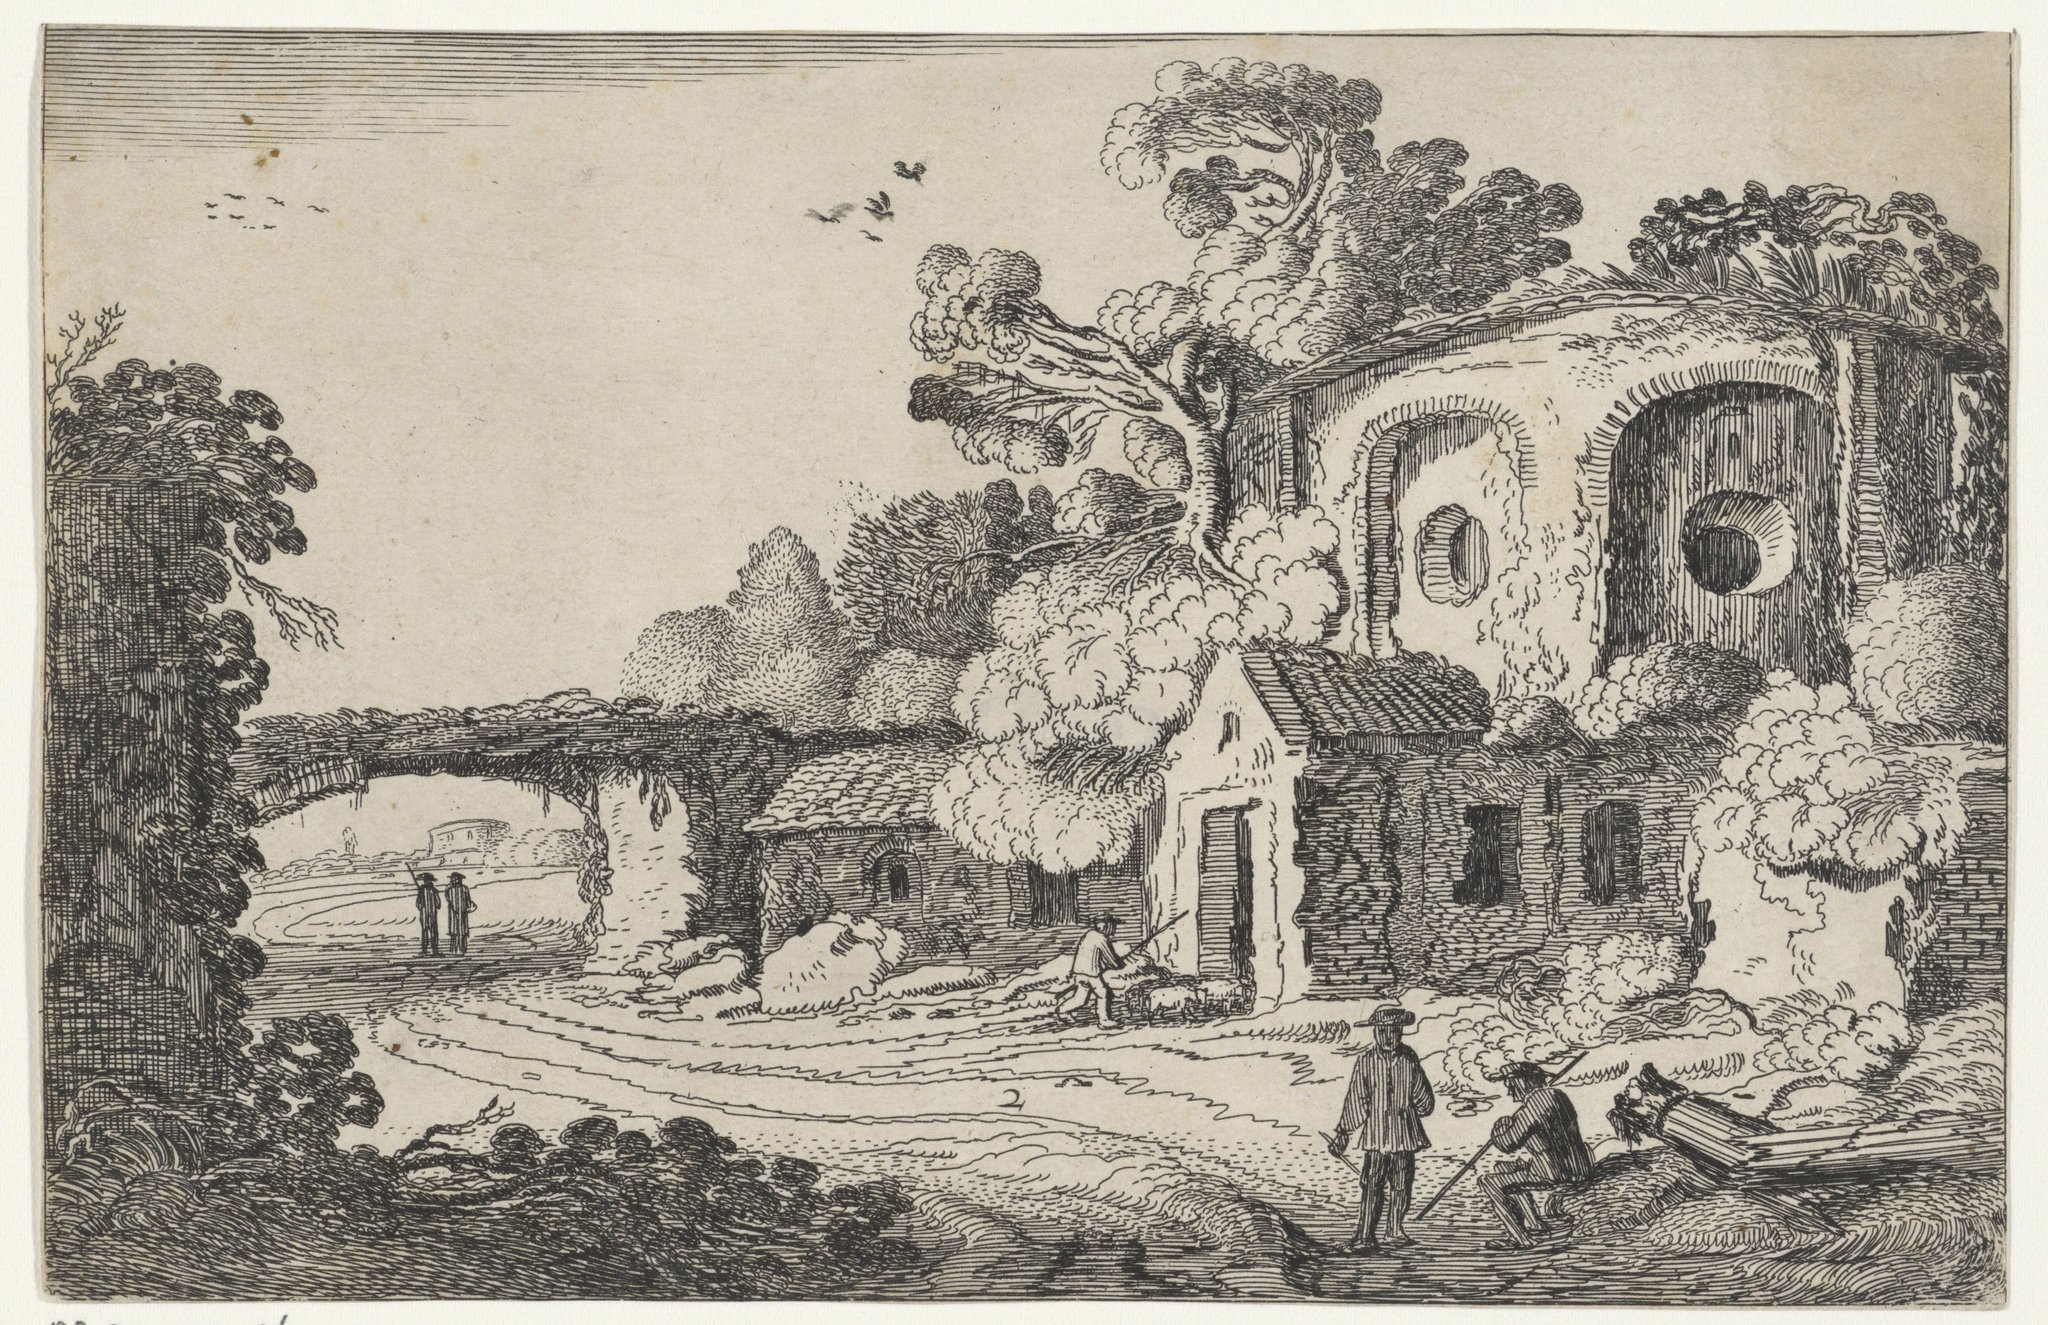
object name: print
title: Ruïnes in landschappen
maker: jan van de velde (ii)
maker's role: draughtsman, painter, print maker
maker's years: 1593-1641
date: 1616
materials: paper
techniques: etching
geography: northern netherlands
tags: landscape with ruins, ruin of a dwelling, house, castle, etc.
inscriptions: collector's mark: Lugt 2228, collector's mark: Lugt 2760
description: Figuren bij een ruïne van een burcht, die is begroeid met bomen en struiken. Tweede prent van een serie van zestien.